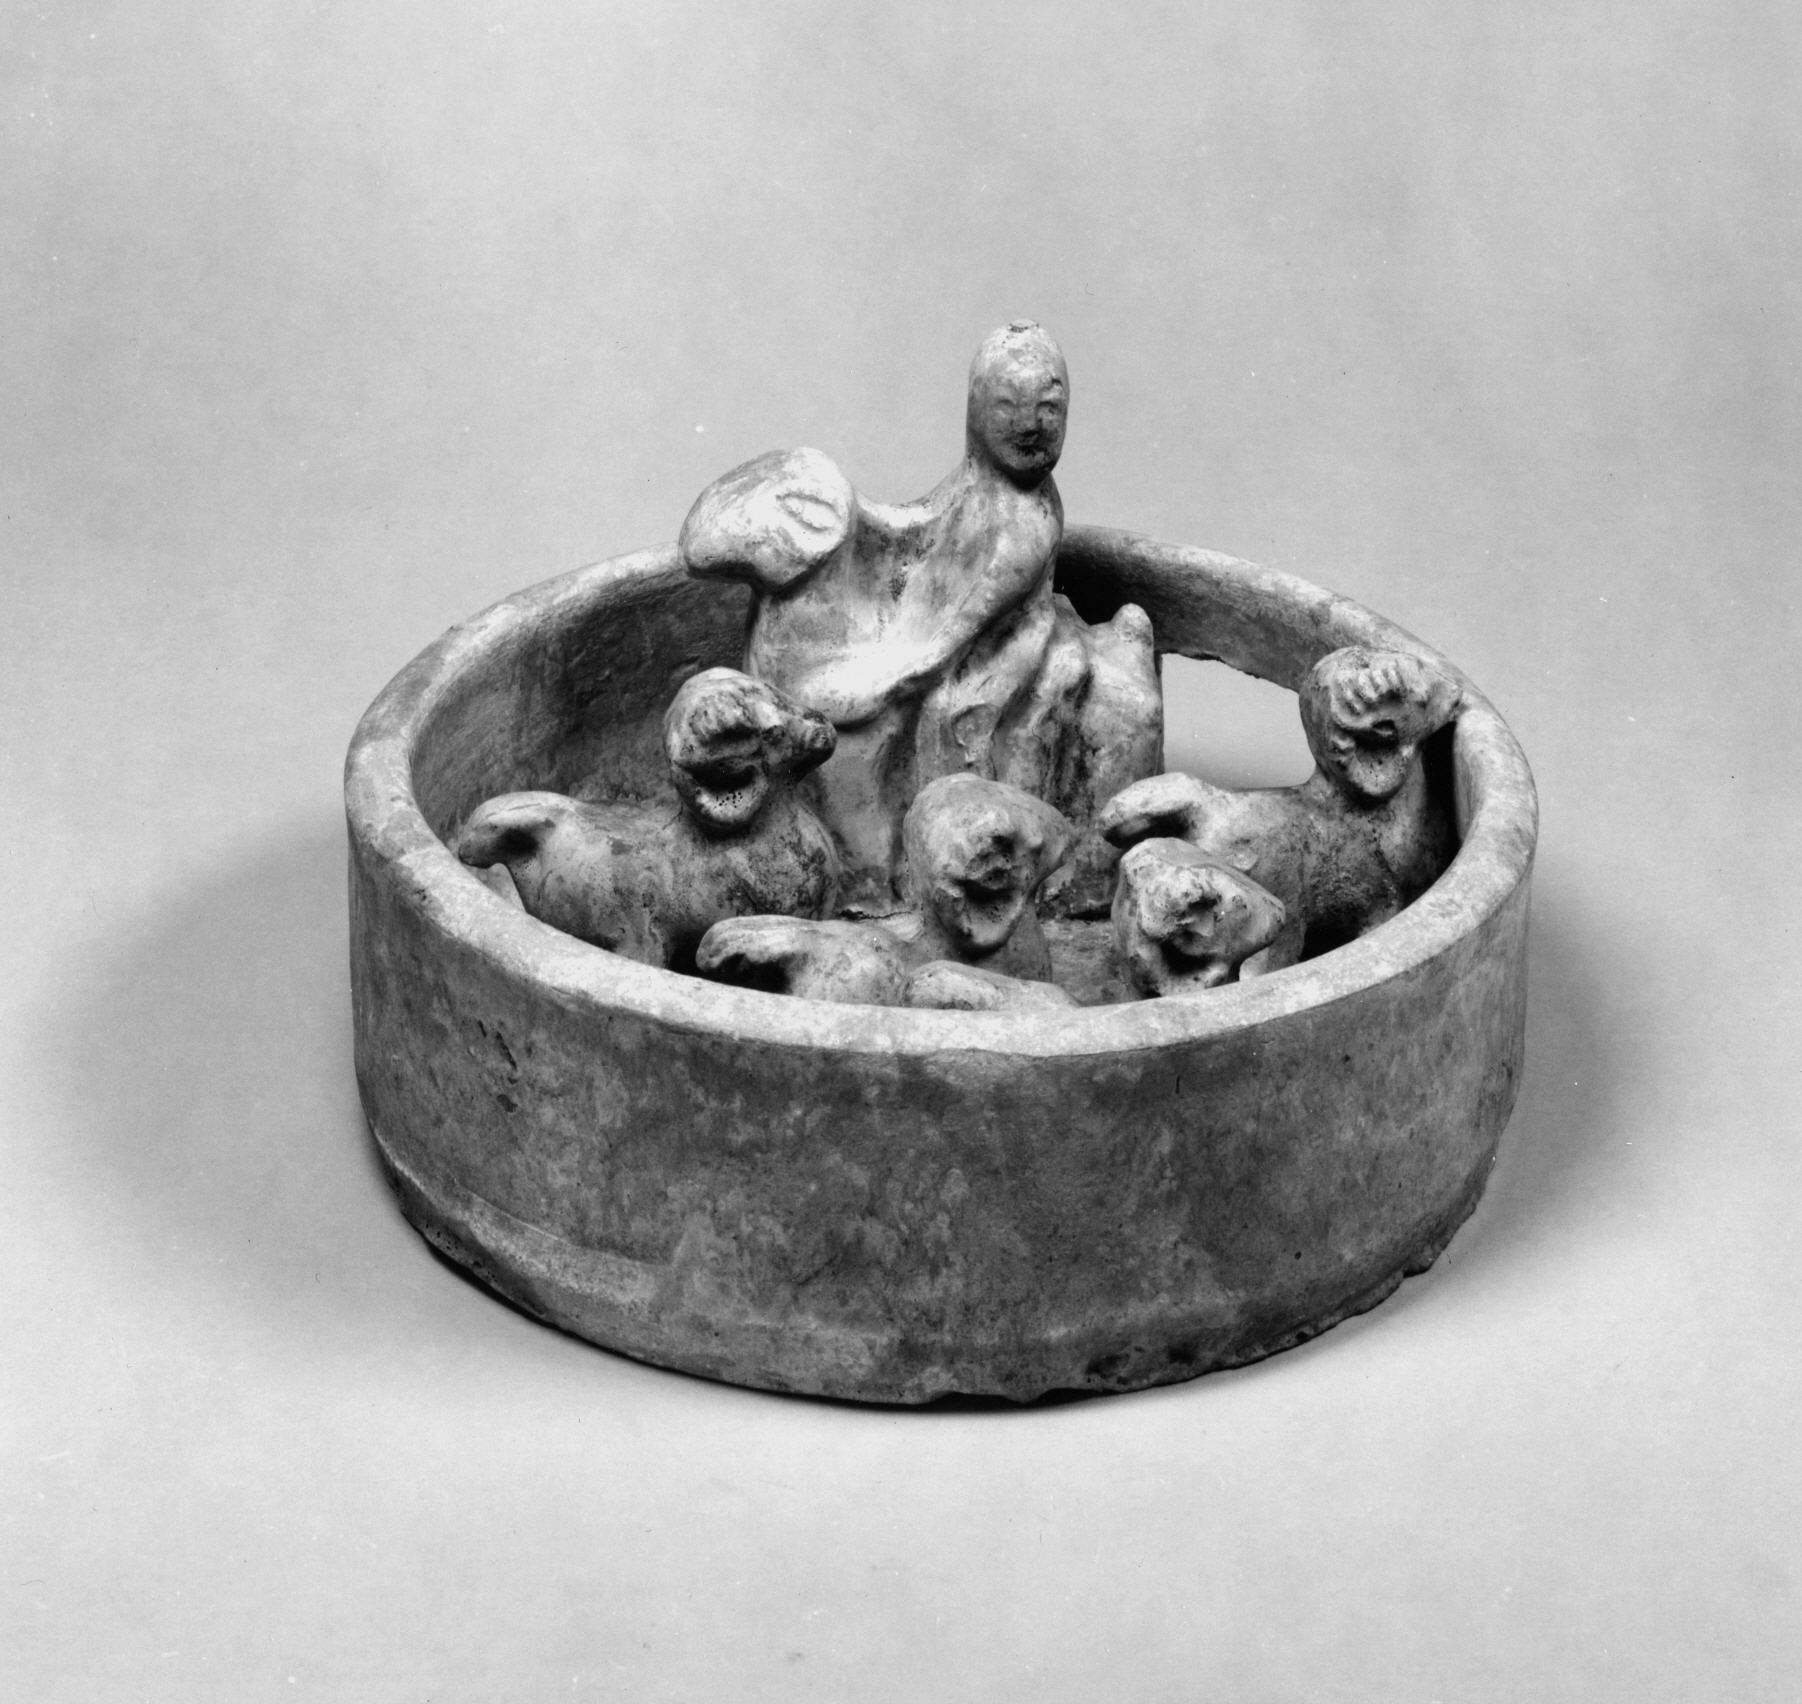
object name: architectural model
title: Circular Ram Pen with Rider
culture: chinese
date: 1-233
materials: earthenware, glaze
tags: rams